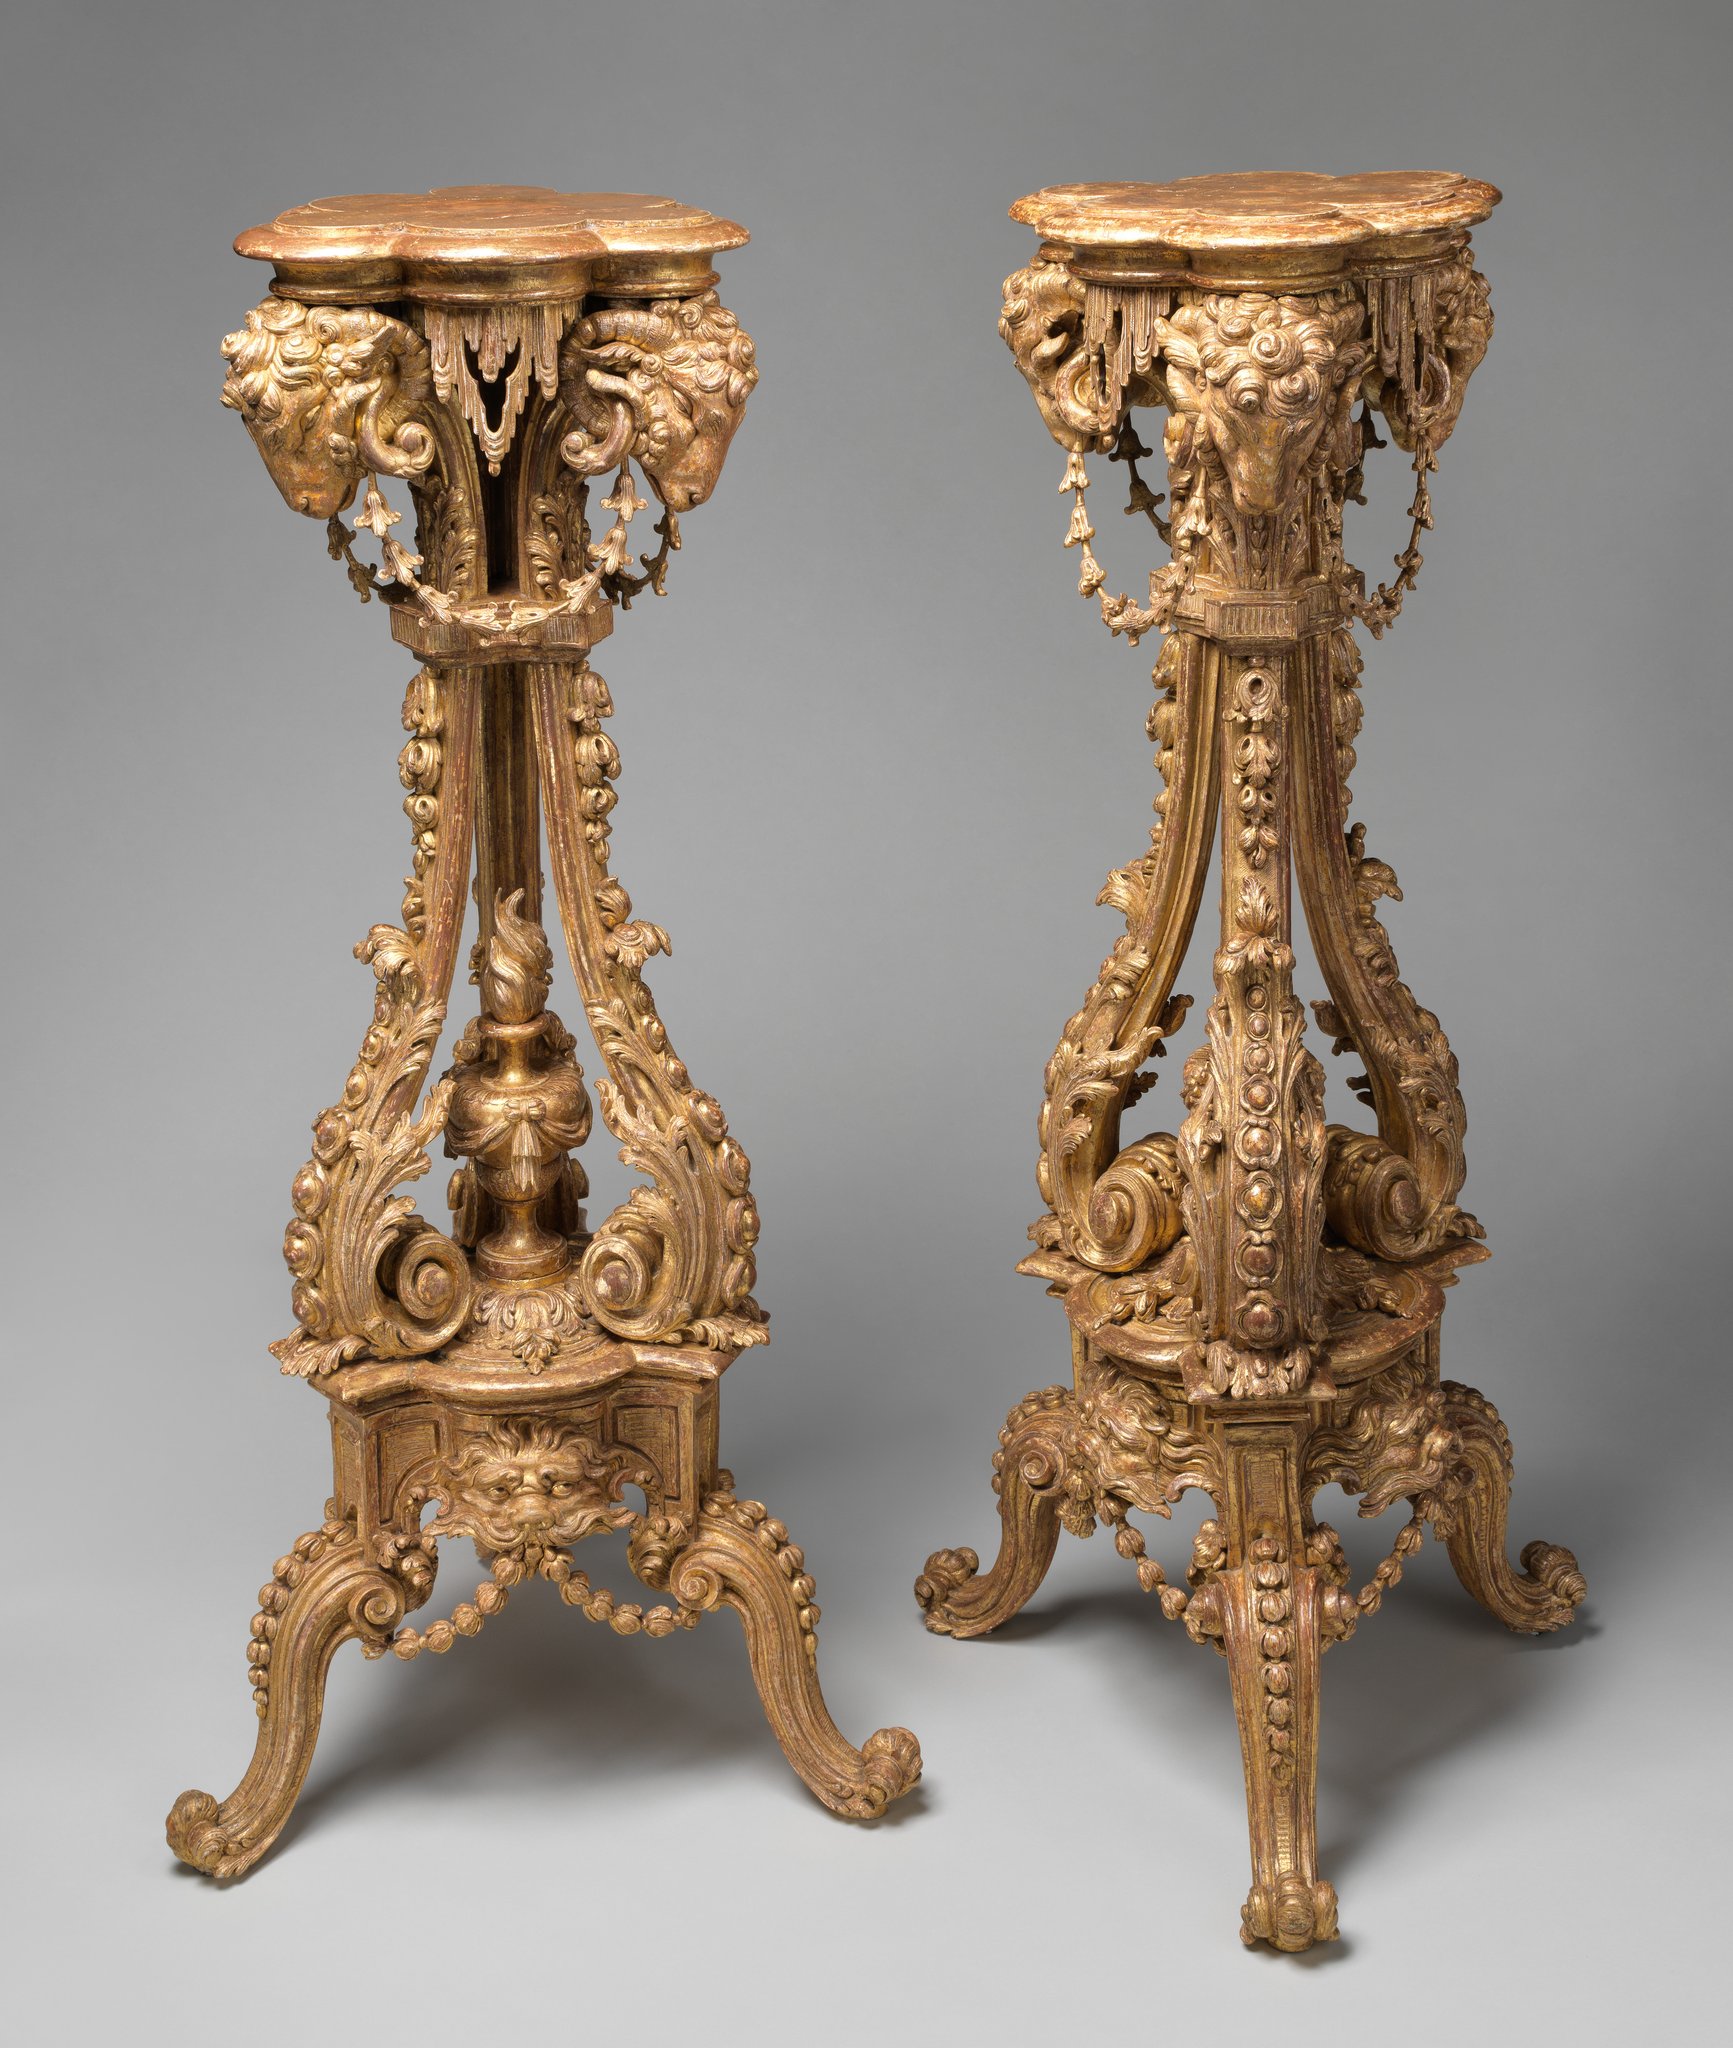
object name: candlestand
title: Pair of tripod candlestands or torchères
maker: thomas chippendale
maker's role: designer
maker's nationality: british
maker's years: 1718-1779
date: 1760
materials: wood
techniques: carving, gilding